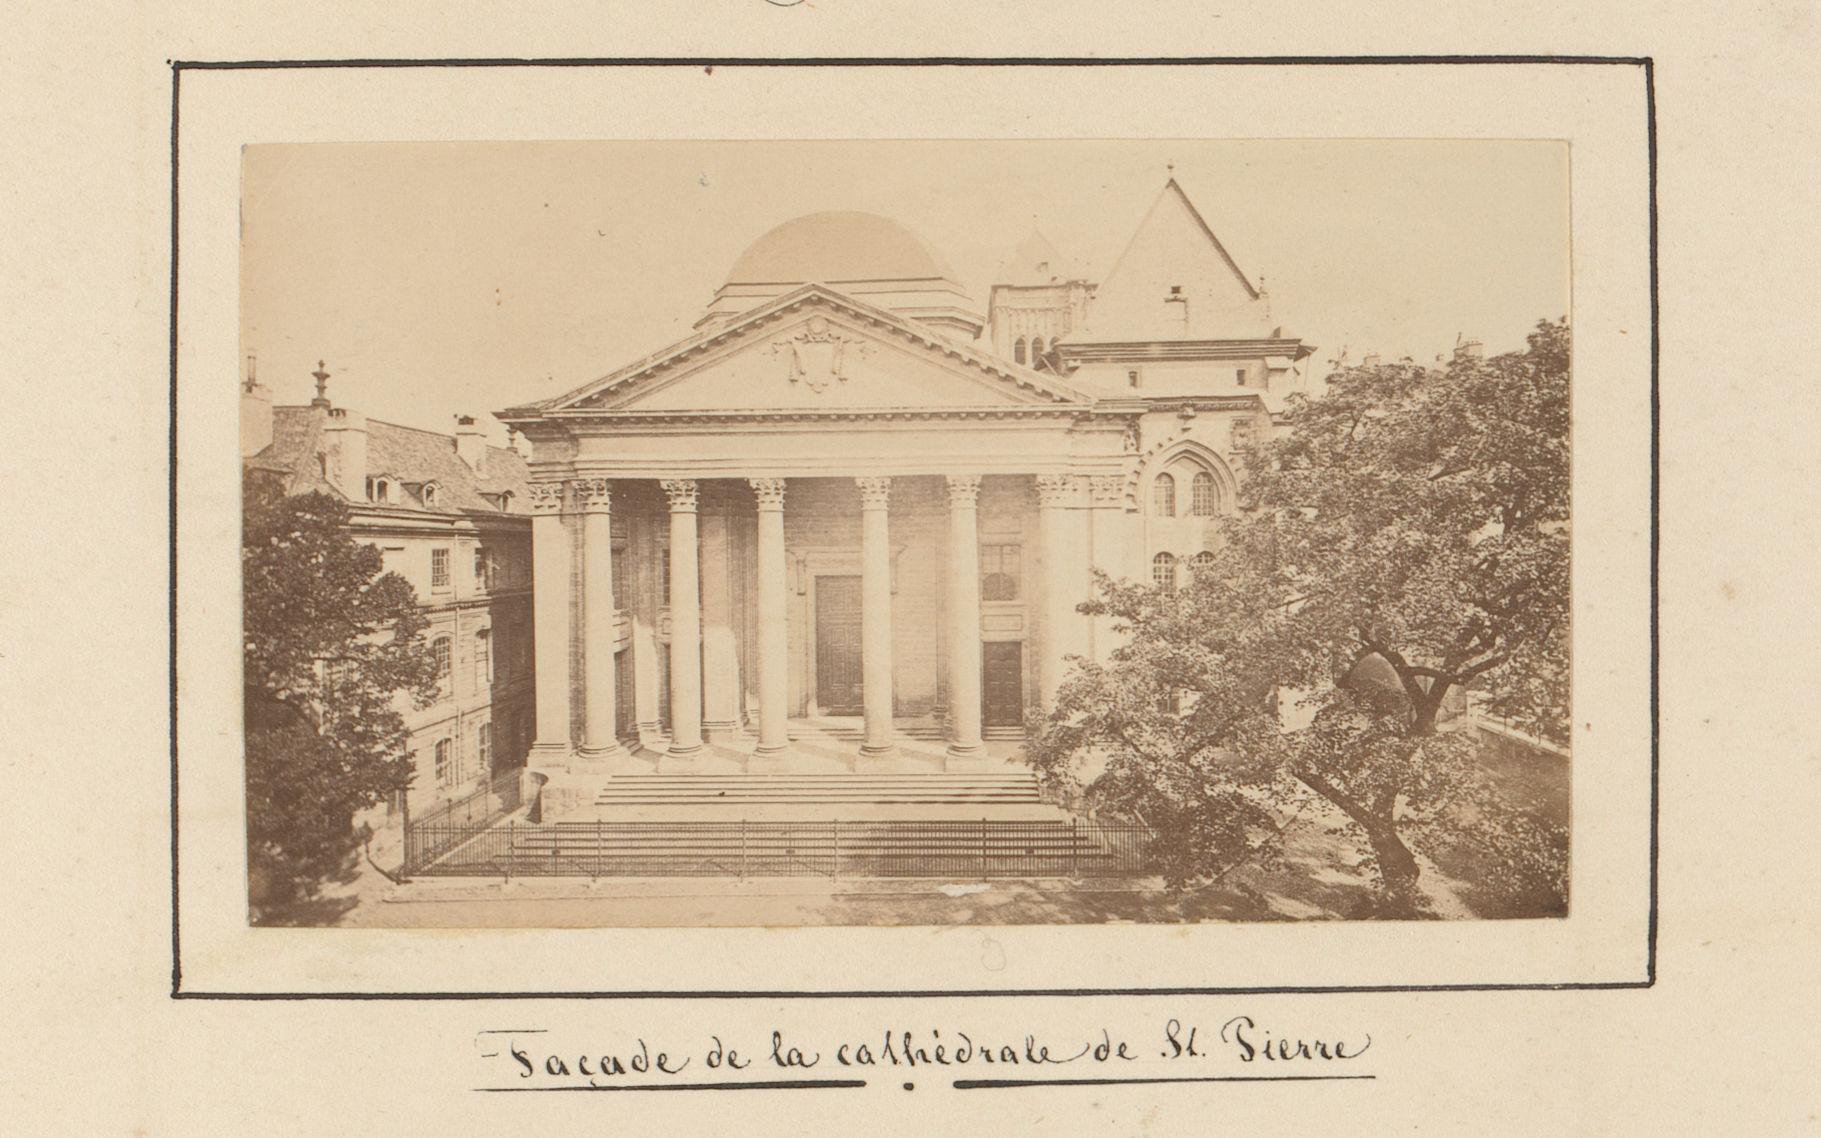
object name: album leaf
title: Exterieur van de kathedraal van Genève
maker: auguste garcin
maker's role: fotograaf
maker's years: 1816-1895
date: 1870-1890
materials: paper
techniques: albumen print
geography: geneva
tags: church (exterior)